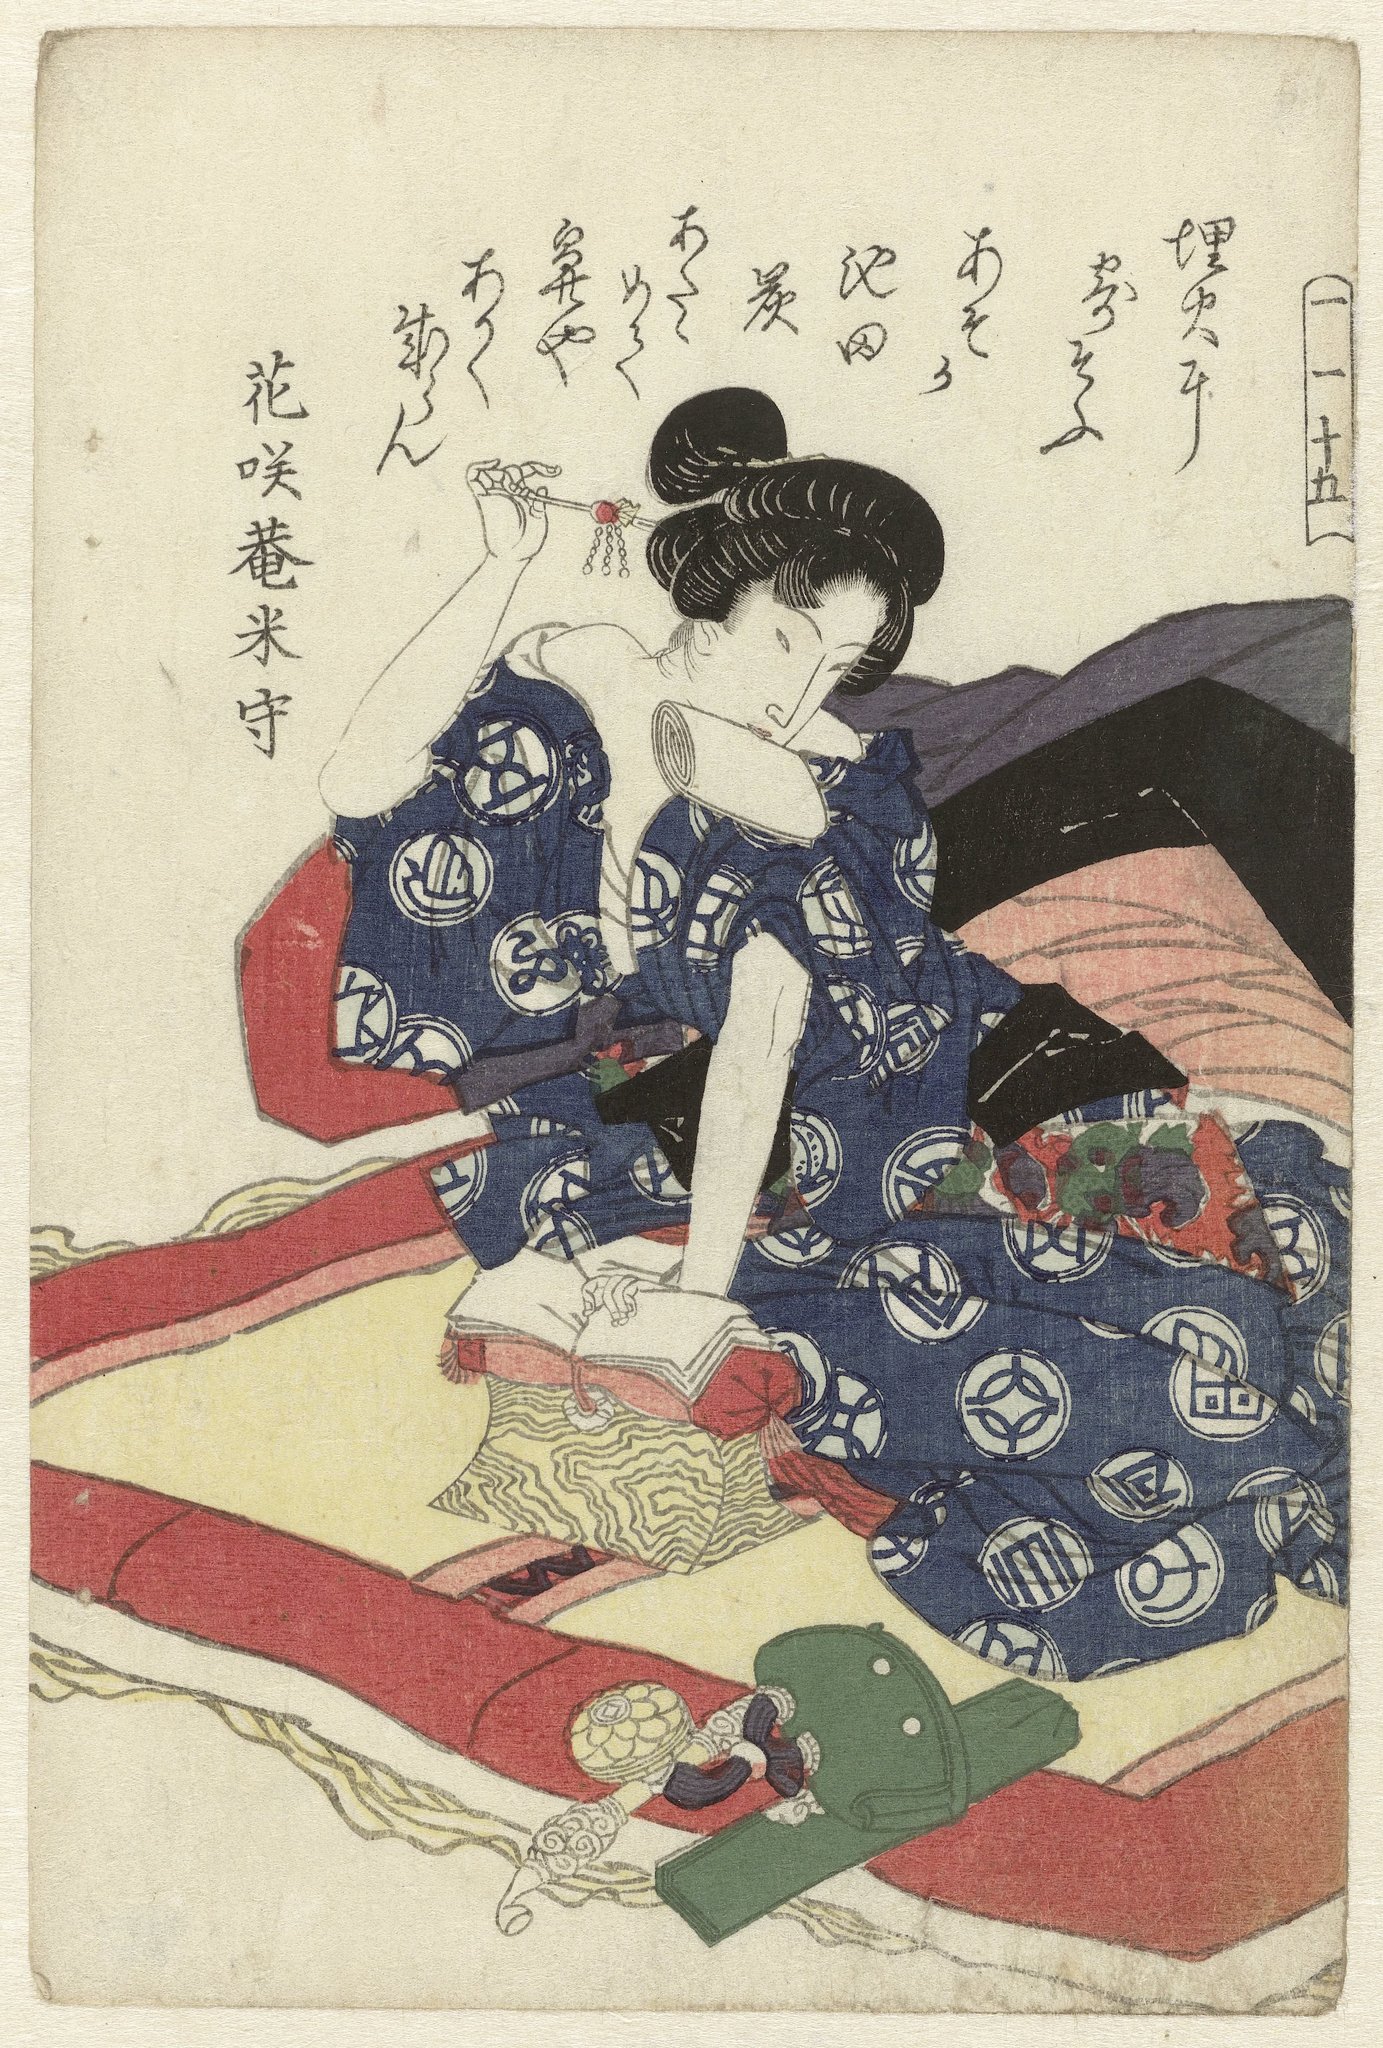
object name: surimono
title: Vrouw slaat futon op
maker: Anonymous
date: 1820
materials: paper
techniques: woodcut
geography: japan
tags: blanket, styles of hairdress - aa - ~ women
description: Een surimono is een luxe uitgevoerde prent waarop beeld met één of meerdere gedichten gecombineerd is. Bij het drukken van een surimono werd vaak gebruik gemaakt van dikker papier, blinddruk en metaal pigmenten, zoals koper- en zilverpoeder. De prenten werden vaak in opdracht van dichters gemaakt en als exclusief geschenk aan vrienden en relaties gegeven.